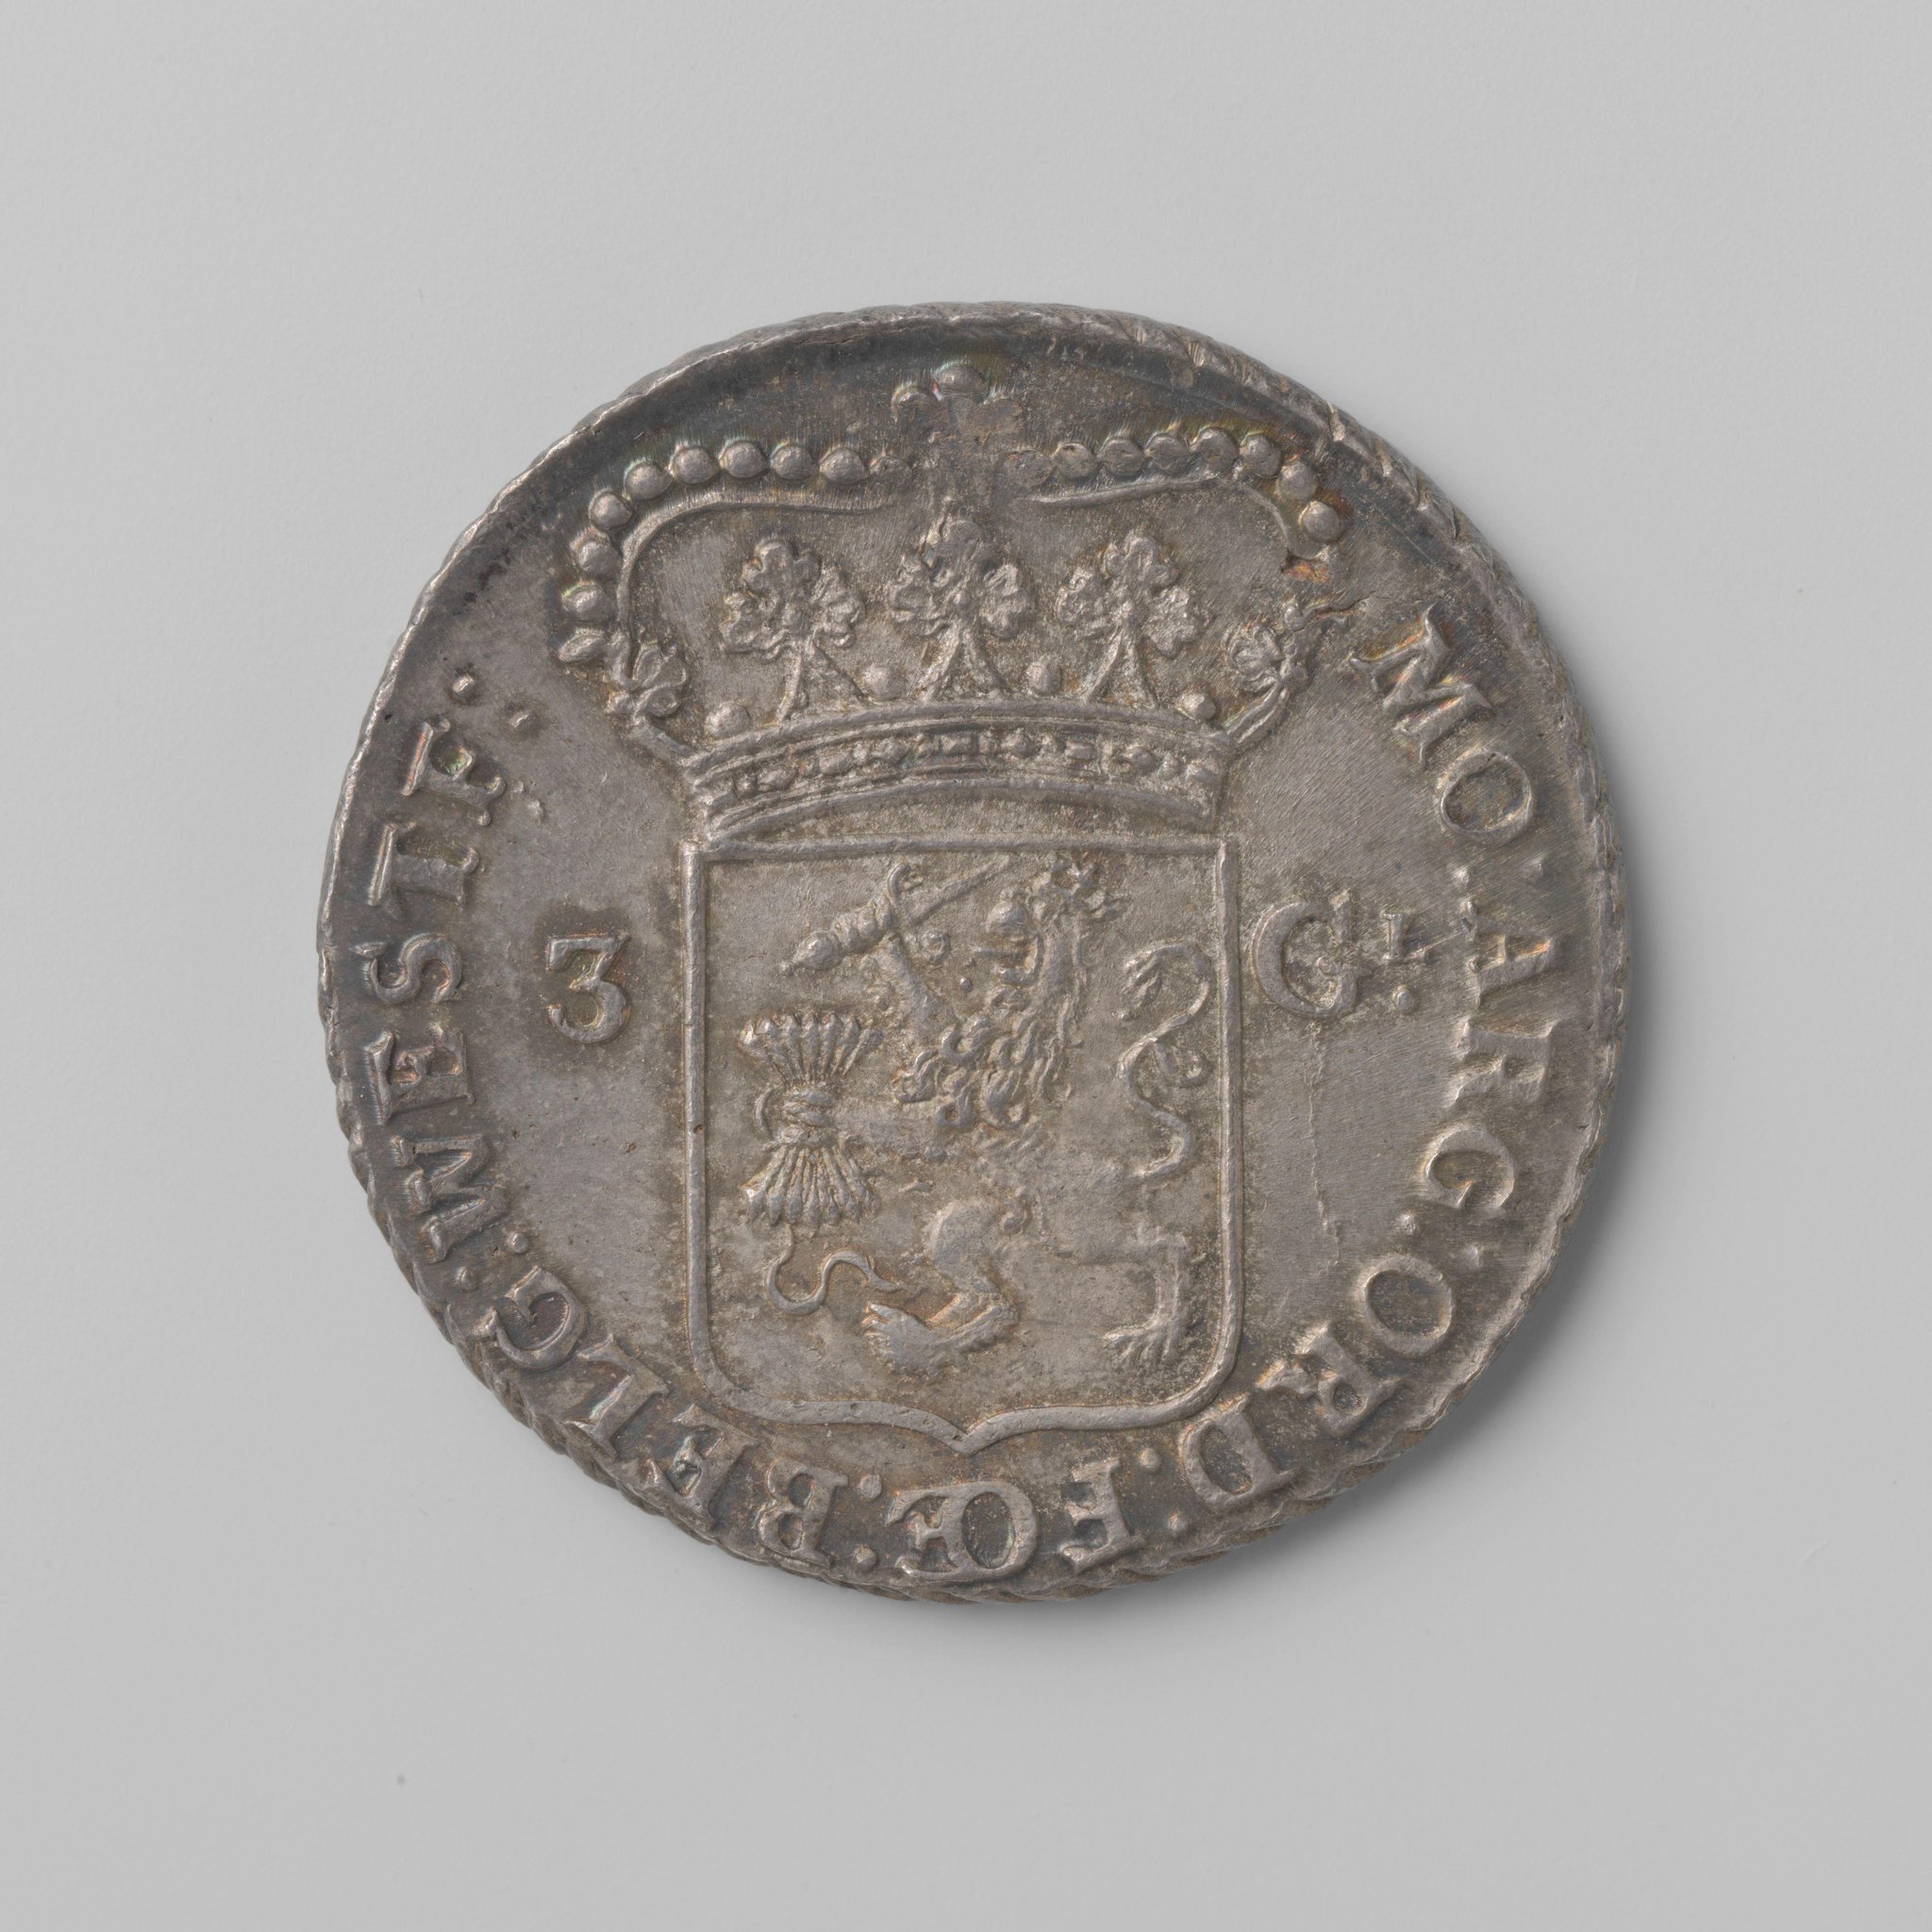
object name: coin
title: West-Friesland, drie gulden, 1793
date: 1793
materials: silver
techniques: striking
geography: west frisia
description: Zilveren munt. Voorzijde: tussen waarde-aanduiding gekroond generaliteirtswapenschild. Keerzijde: Nederlandse maagd met vrijheidshoed en speer, leunend op een bijbel op een altaar. In afsnede jaartal. Kabelrand.